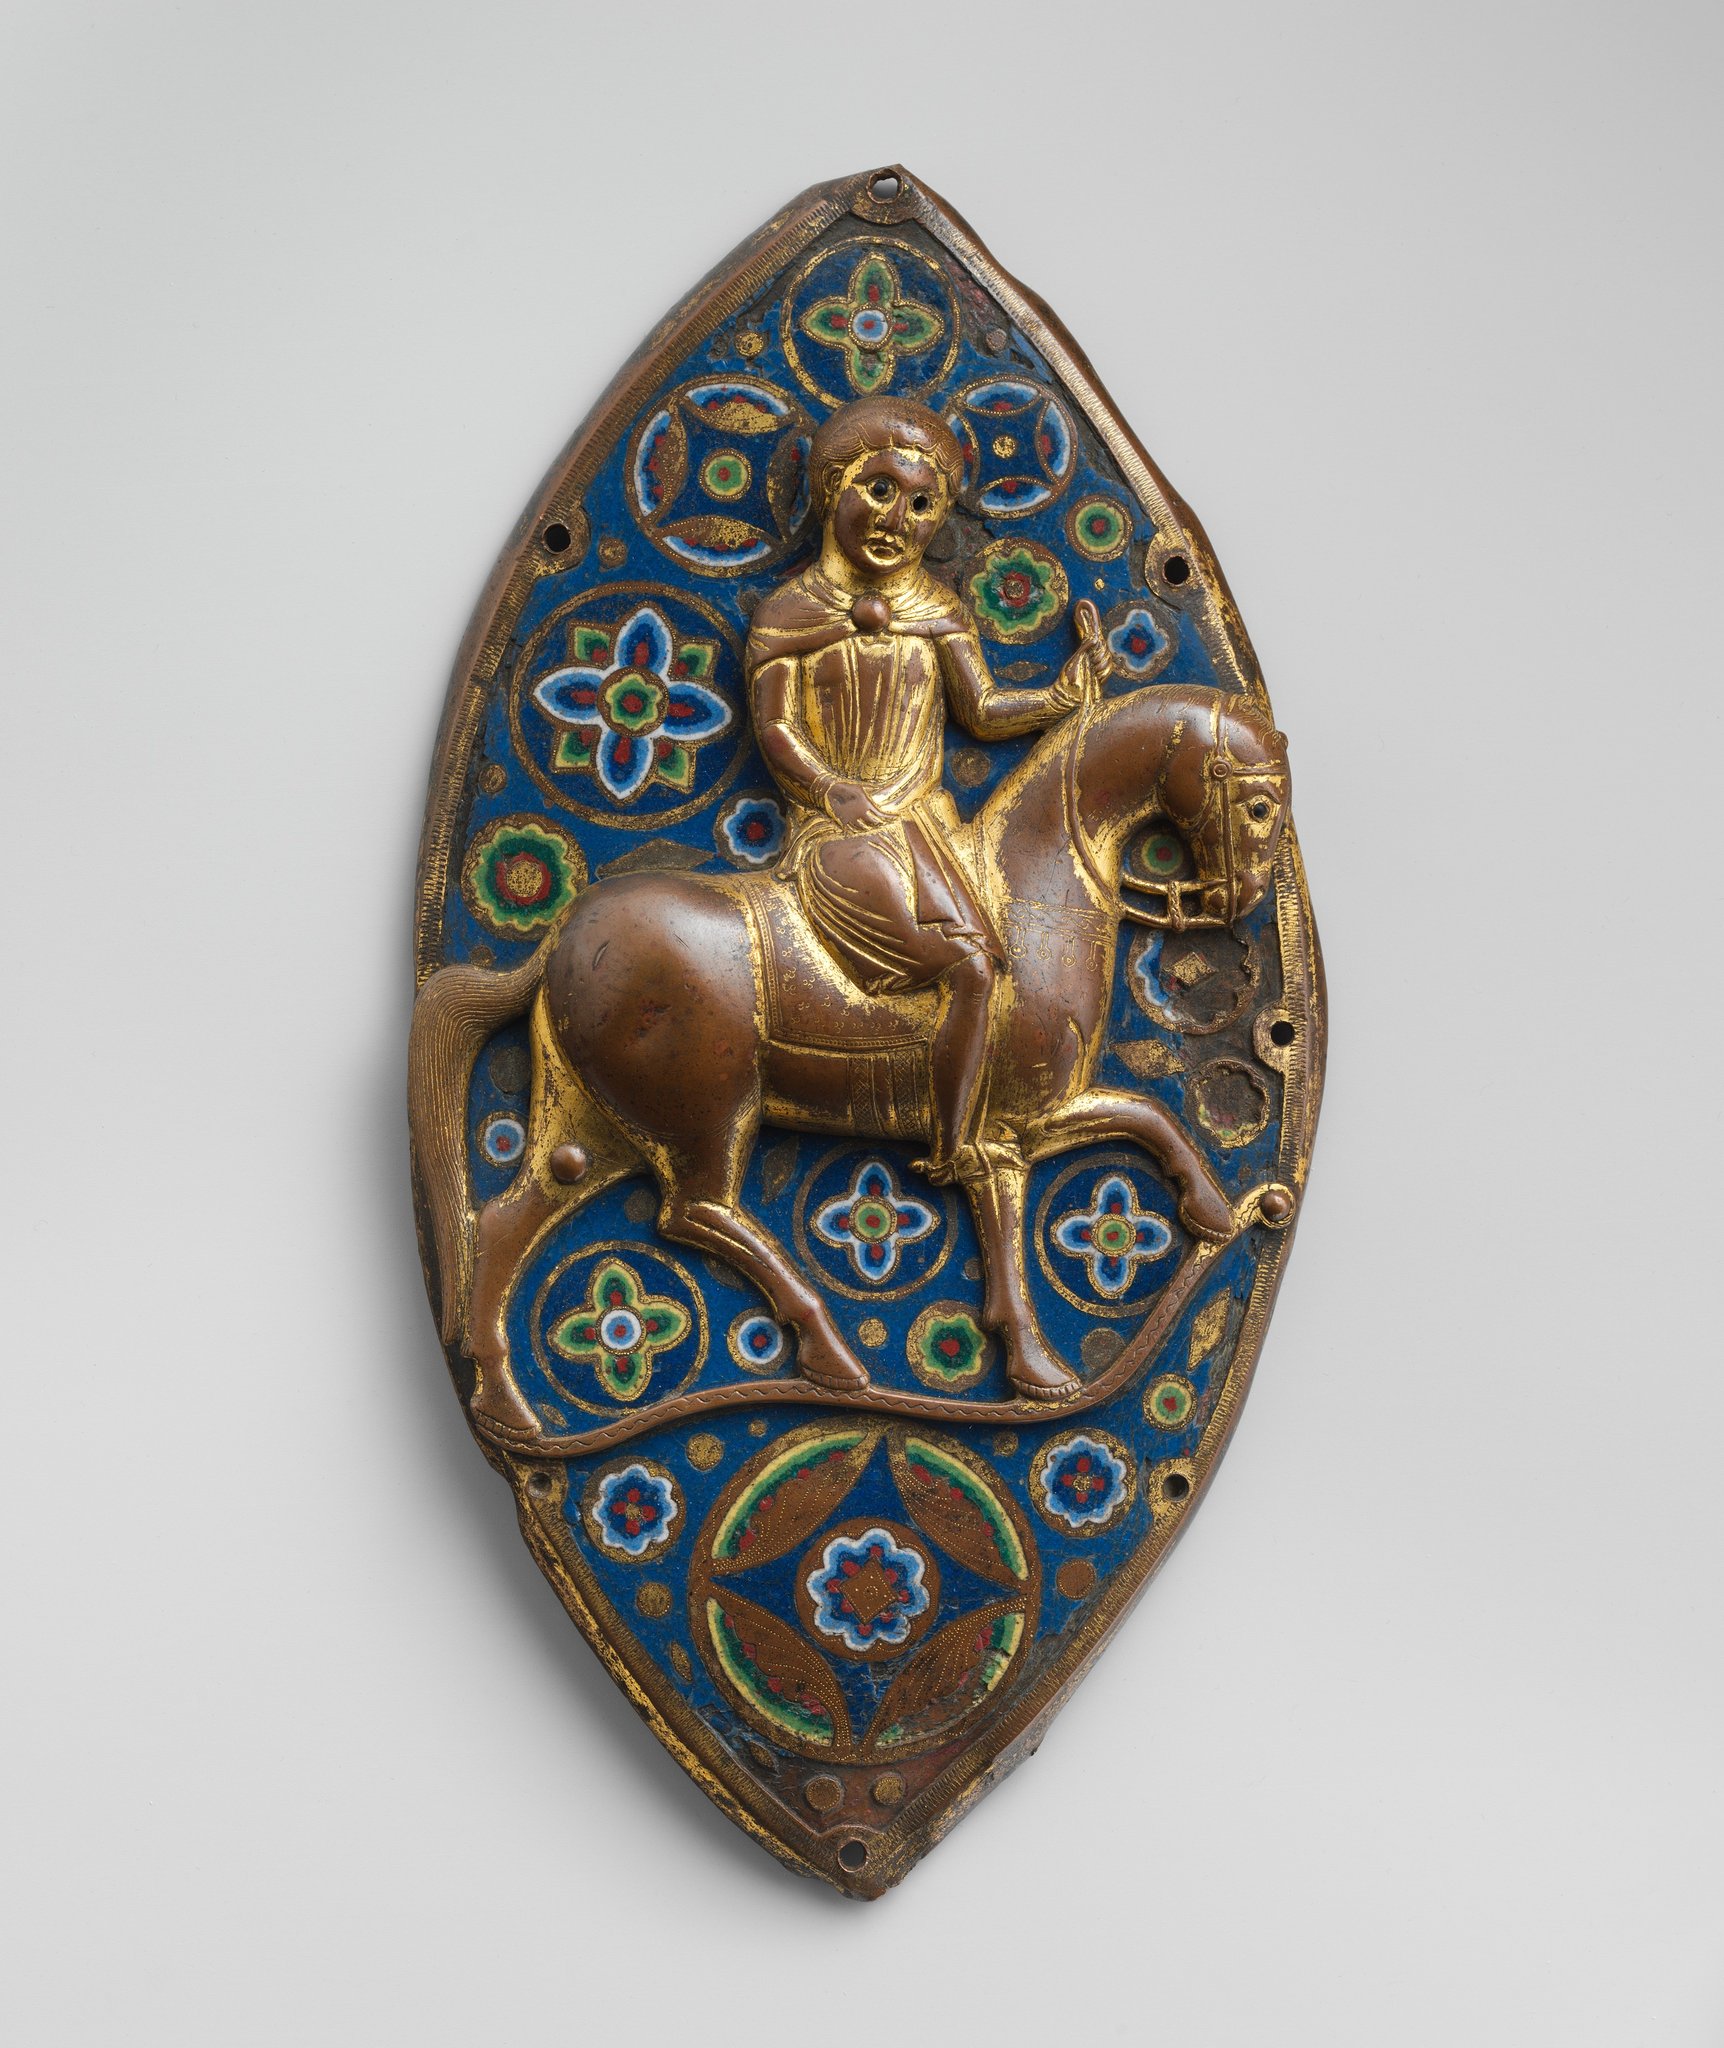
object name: plaque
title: Equestrian Plaque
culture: french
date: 1220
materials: enamel, gilt copper, glass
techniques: enamel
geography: france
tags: men